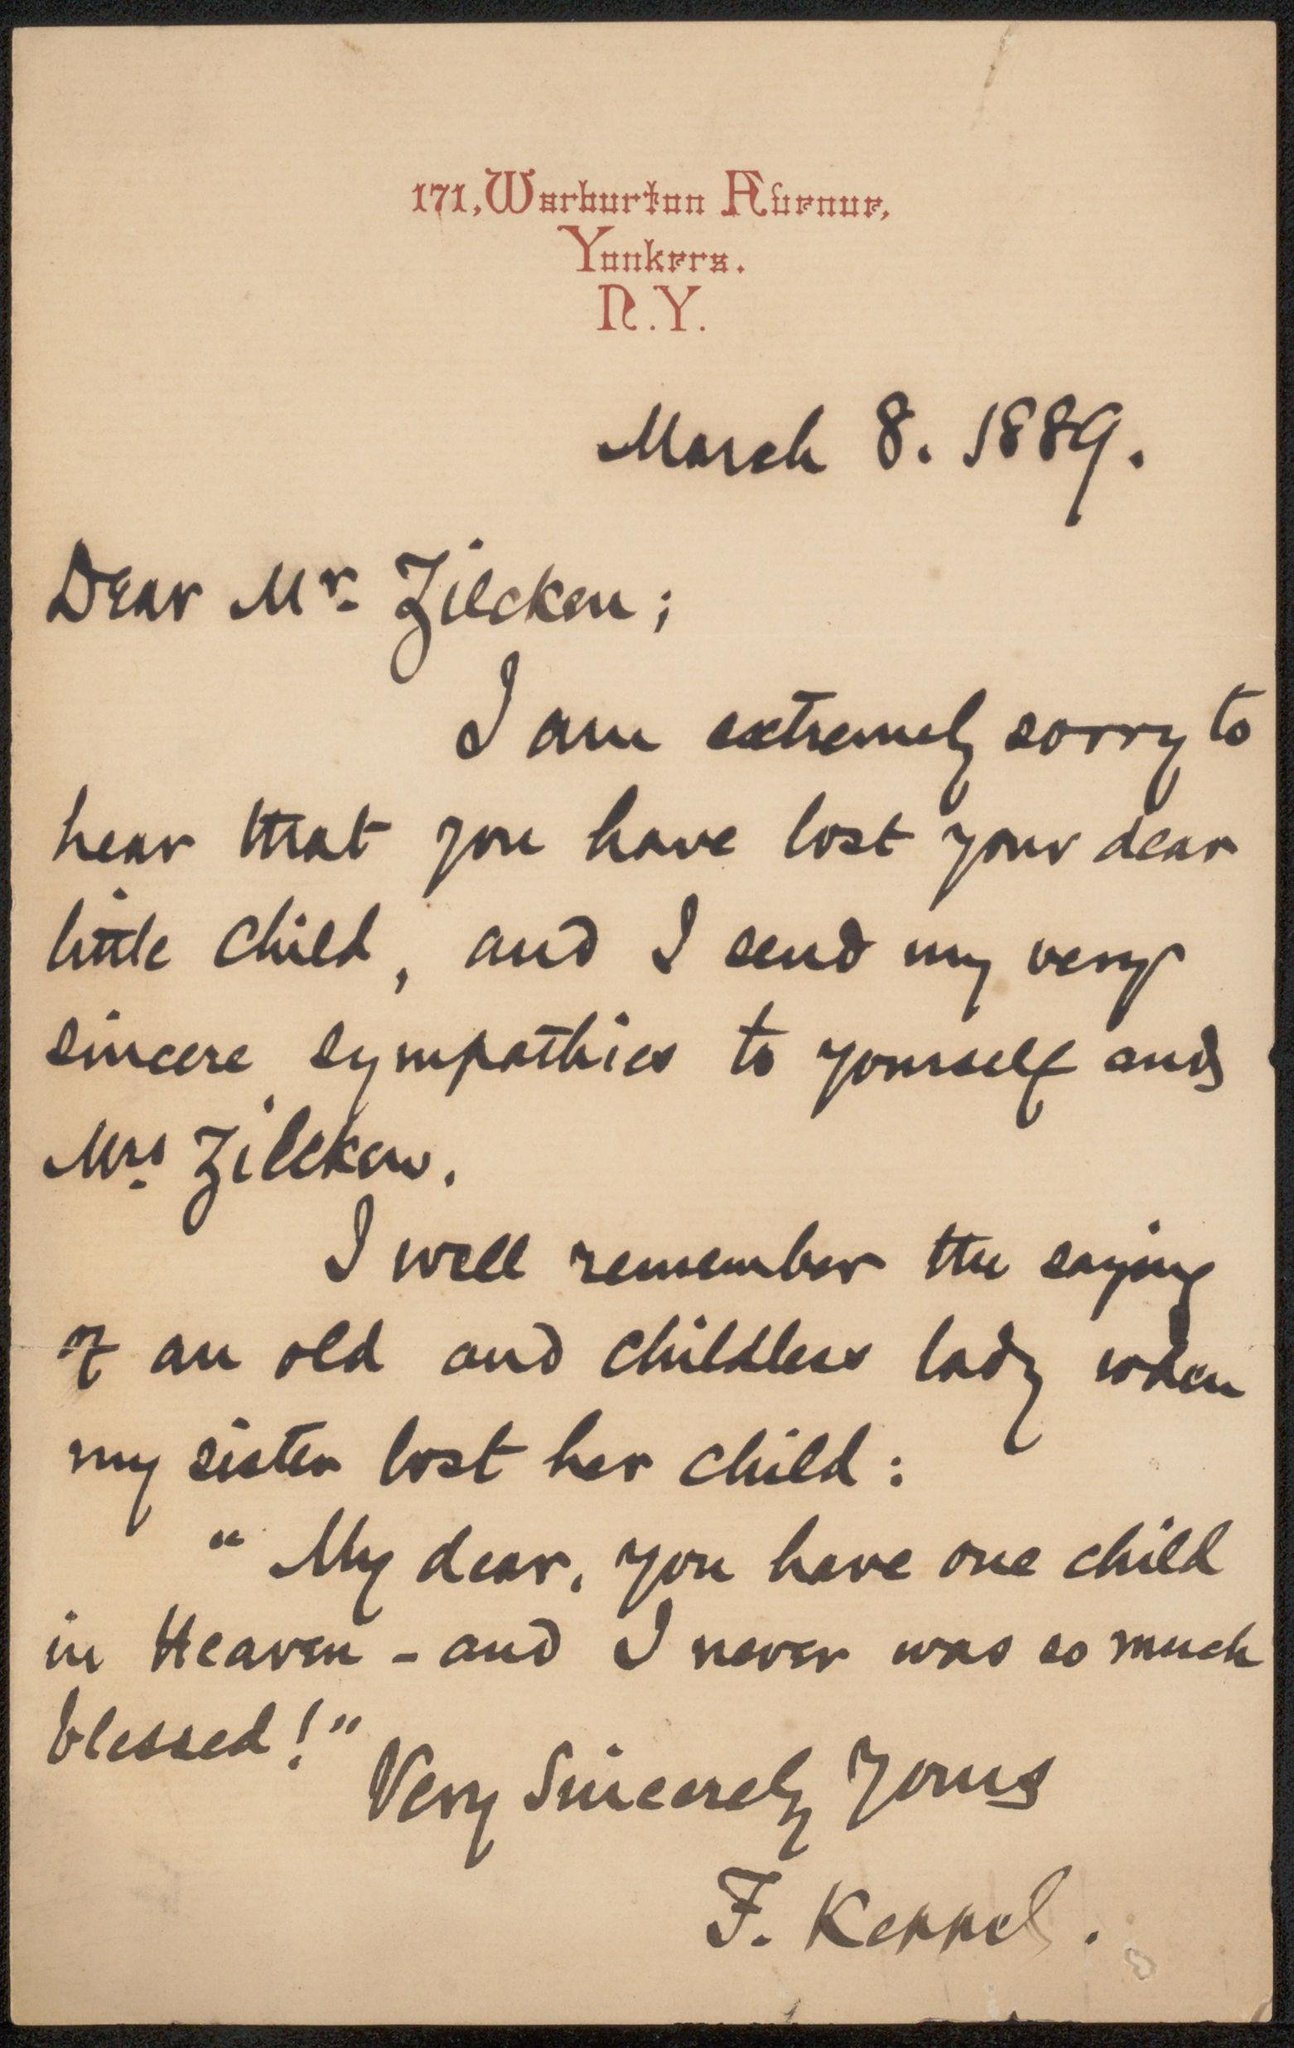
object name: letter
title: Brief aan Philip Zilcken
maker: frederick keppel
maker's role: criticus, kunsthandelaar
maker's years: 1845-1912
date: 1889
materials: ink, paper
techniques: pen, printing, writing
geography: new york city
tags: painter, philip zilcken, family life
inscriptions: watermark